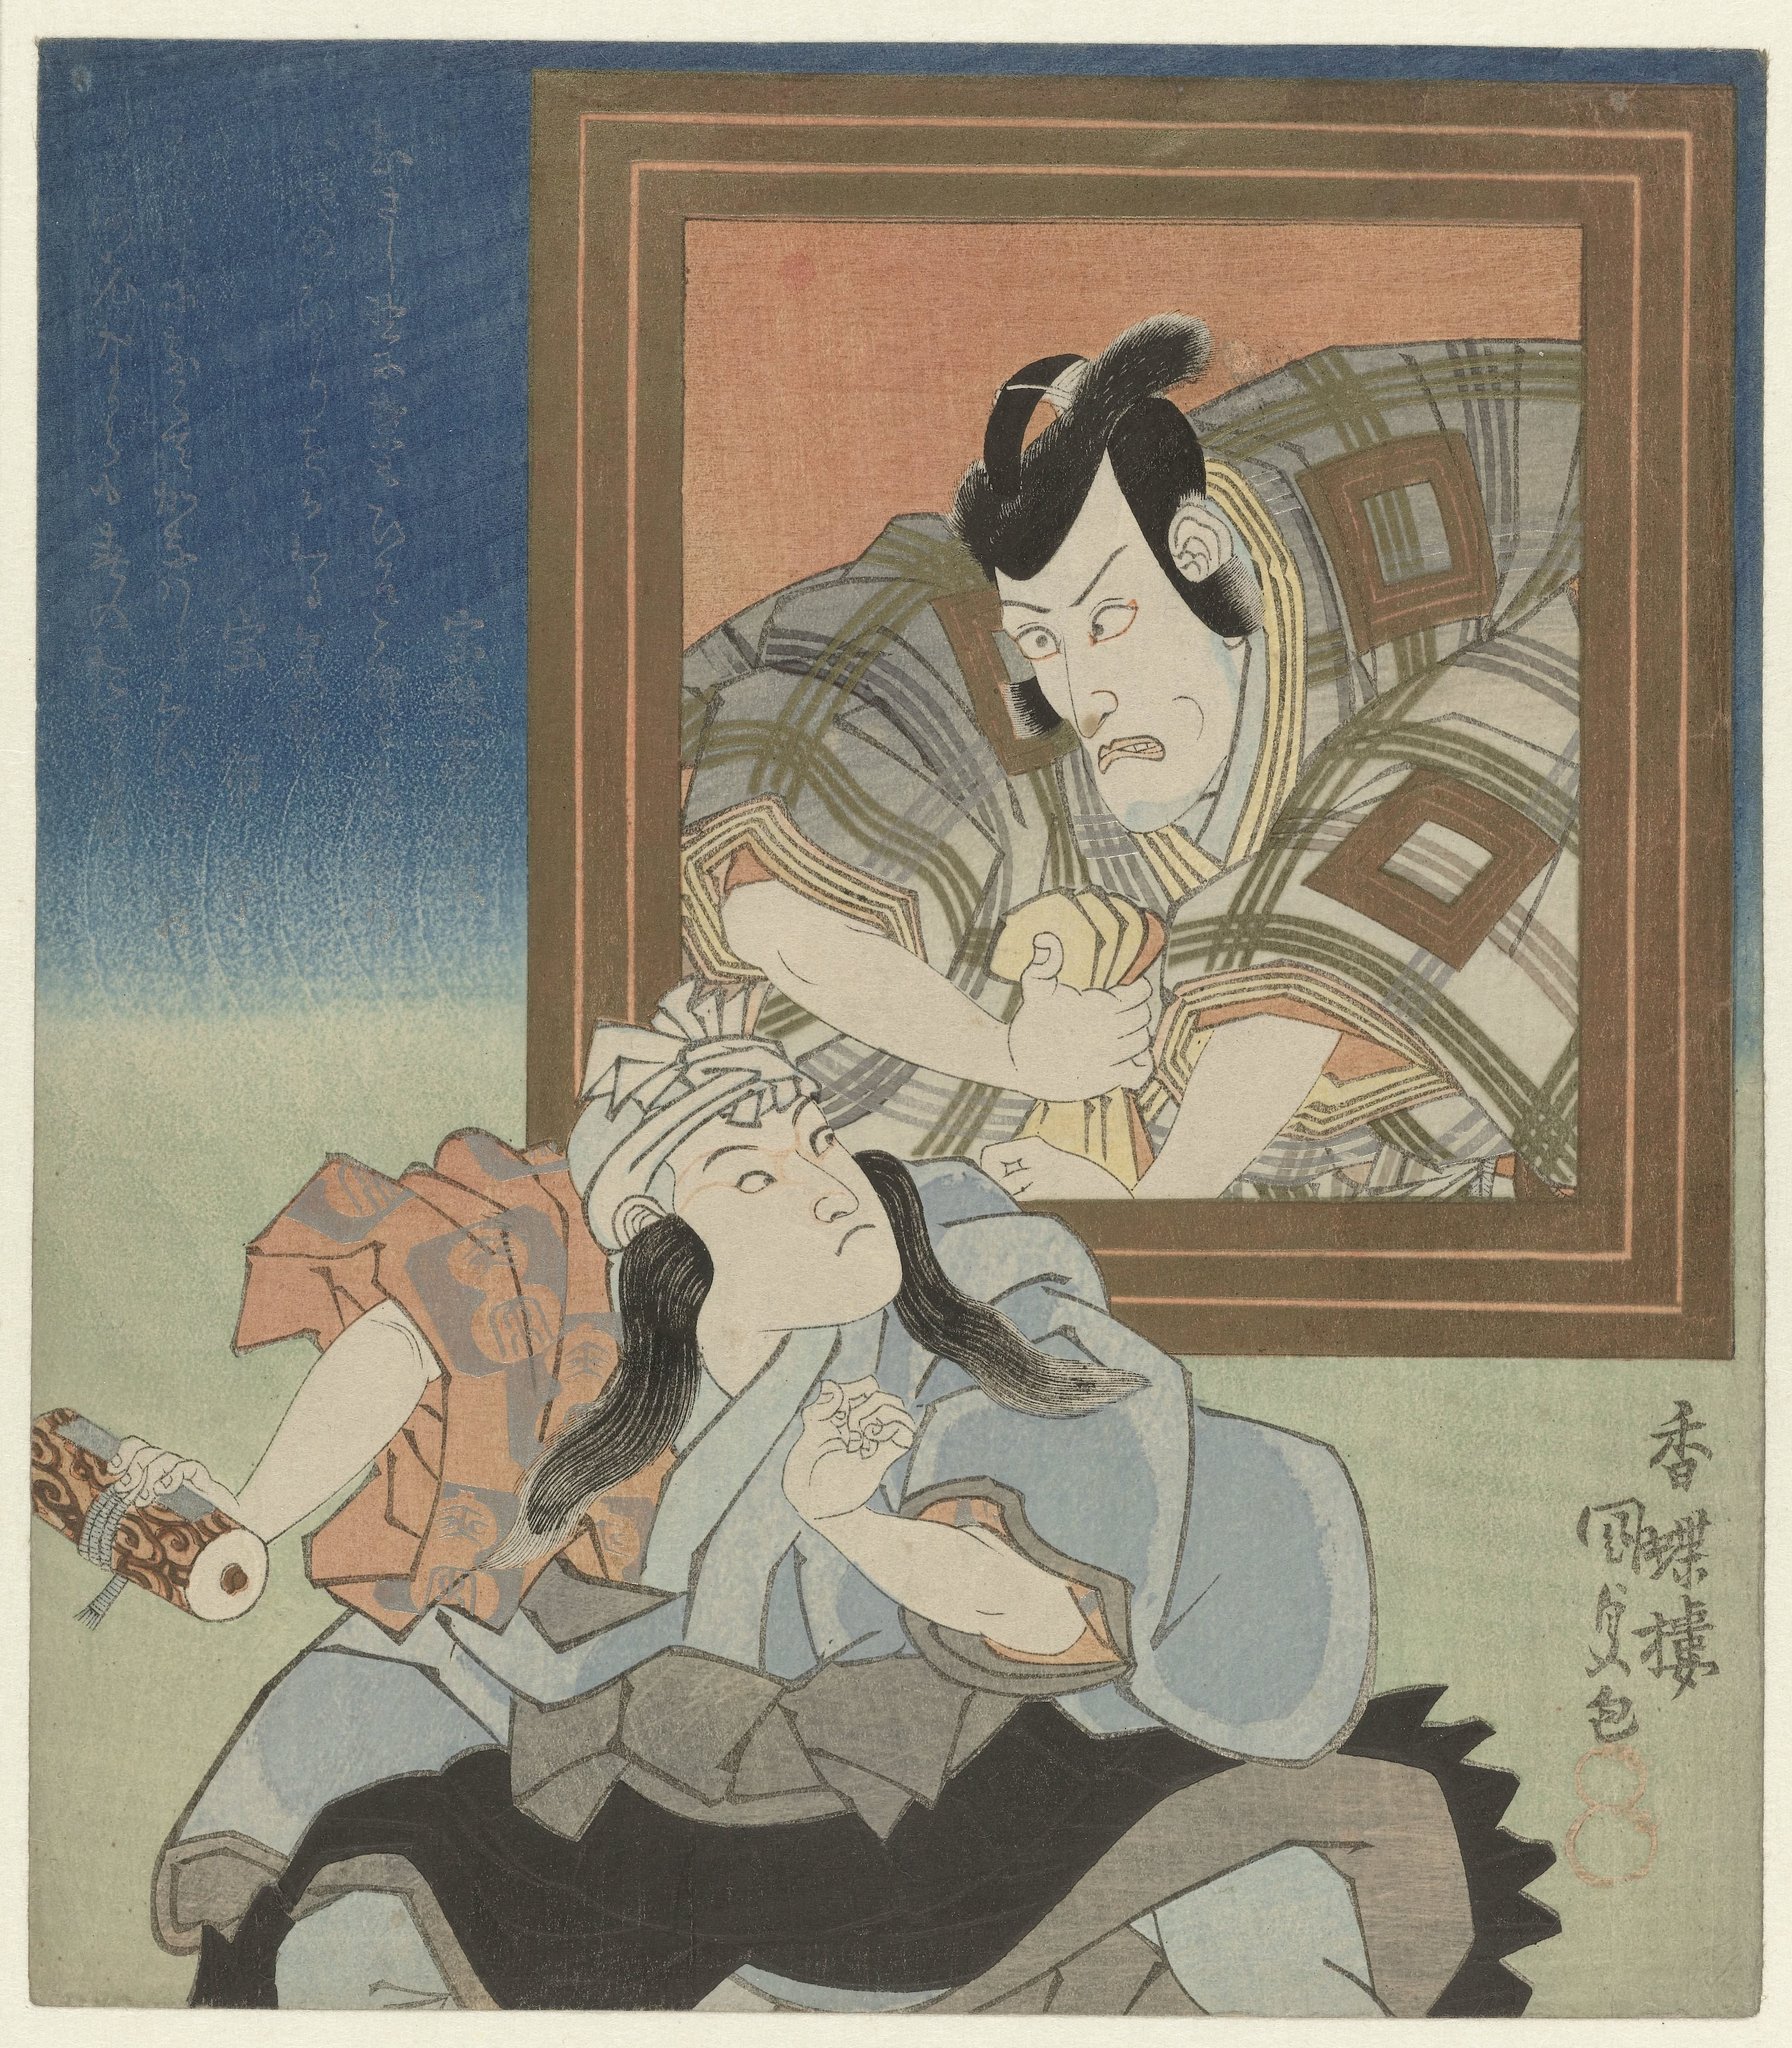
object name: surimono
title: Jonge acteur bij een portret van Ichikawa Danjûrô VII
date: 1831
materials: paper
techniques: blind stamped, woodcut, polish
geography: japan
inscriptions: collector's mark, verso, stamped: Lugt 2228, collector's mark, passe-partout, bottom left, printed: JABdH with a rooster.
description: Vanuit een cartouche kijkt een man naar een jongen met een rol in zijn hand. De jongen is de 8-jarige acteur Ichikawa Ebizô (1823-54), in de rol van Kobôzu Donguri. In het cartouche is zijn vader afgebeeld, acteur Ichikawa Danjûrô VII (1791-1859). Scene uit het toneelstuk Ichiyoraifuku Shibuya no tsuwamono, opgevoerd in het Kawarazaki theater in Edo (huidig Tokio) in 1830 . Met twee gedichten.